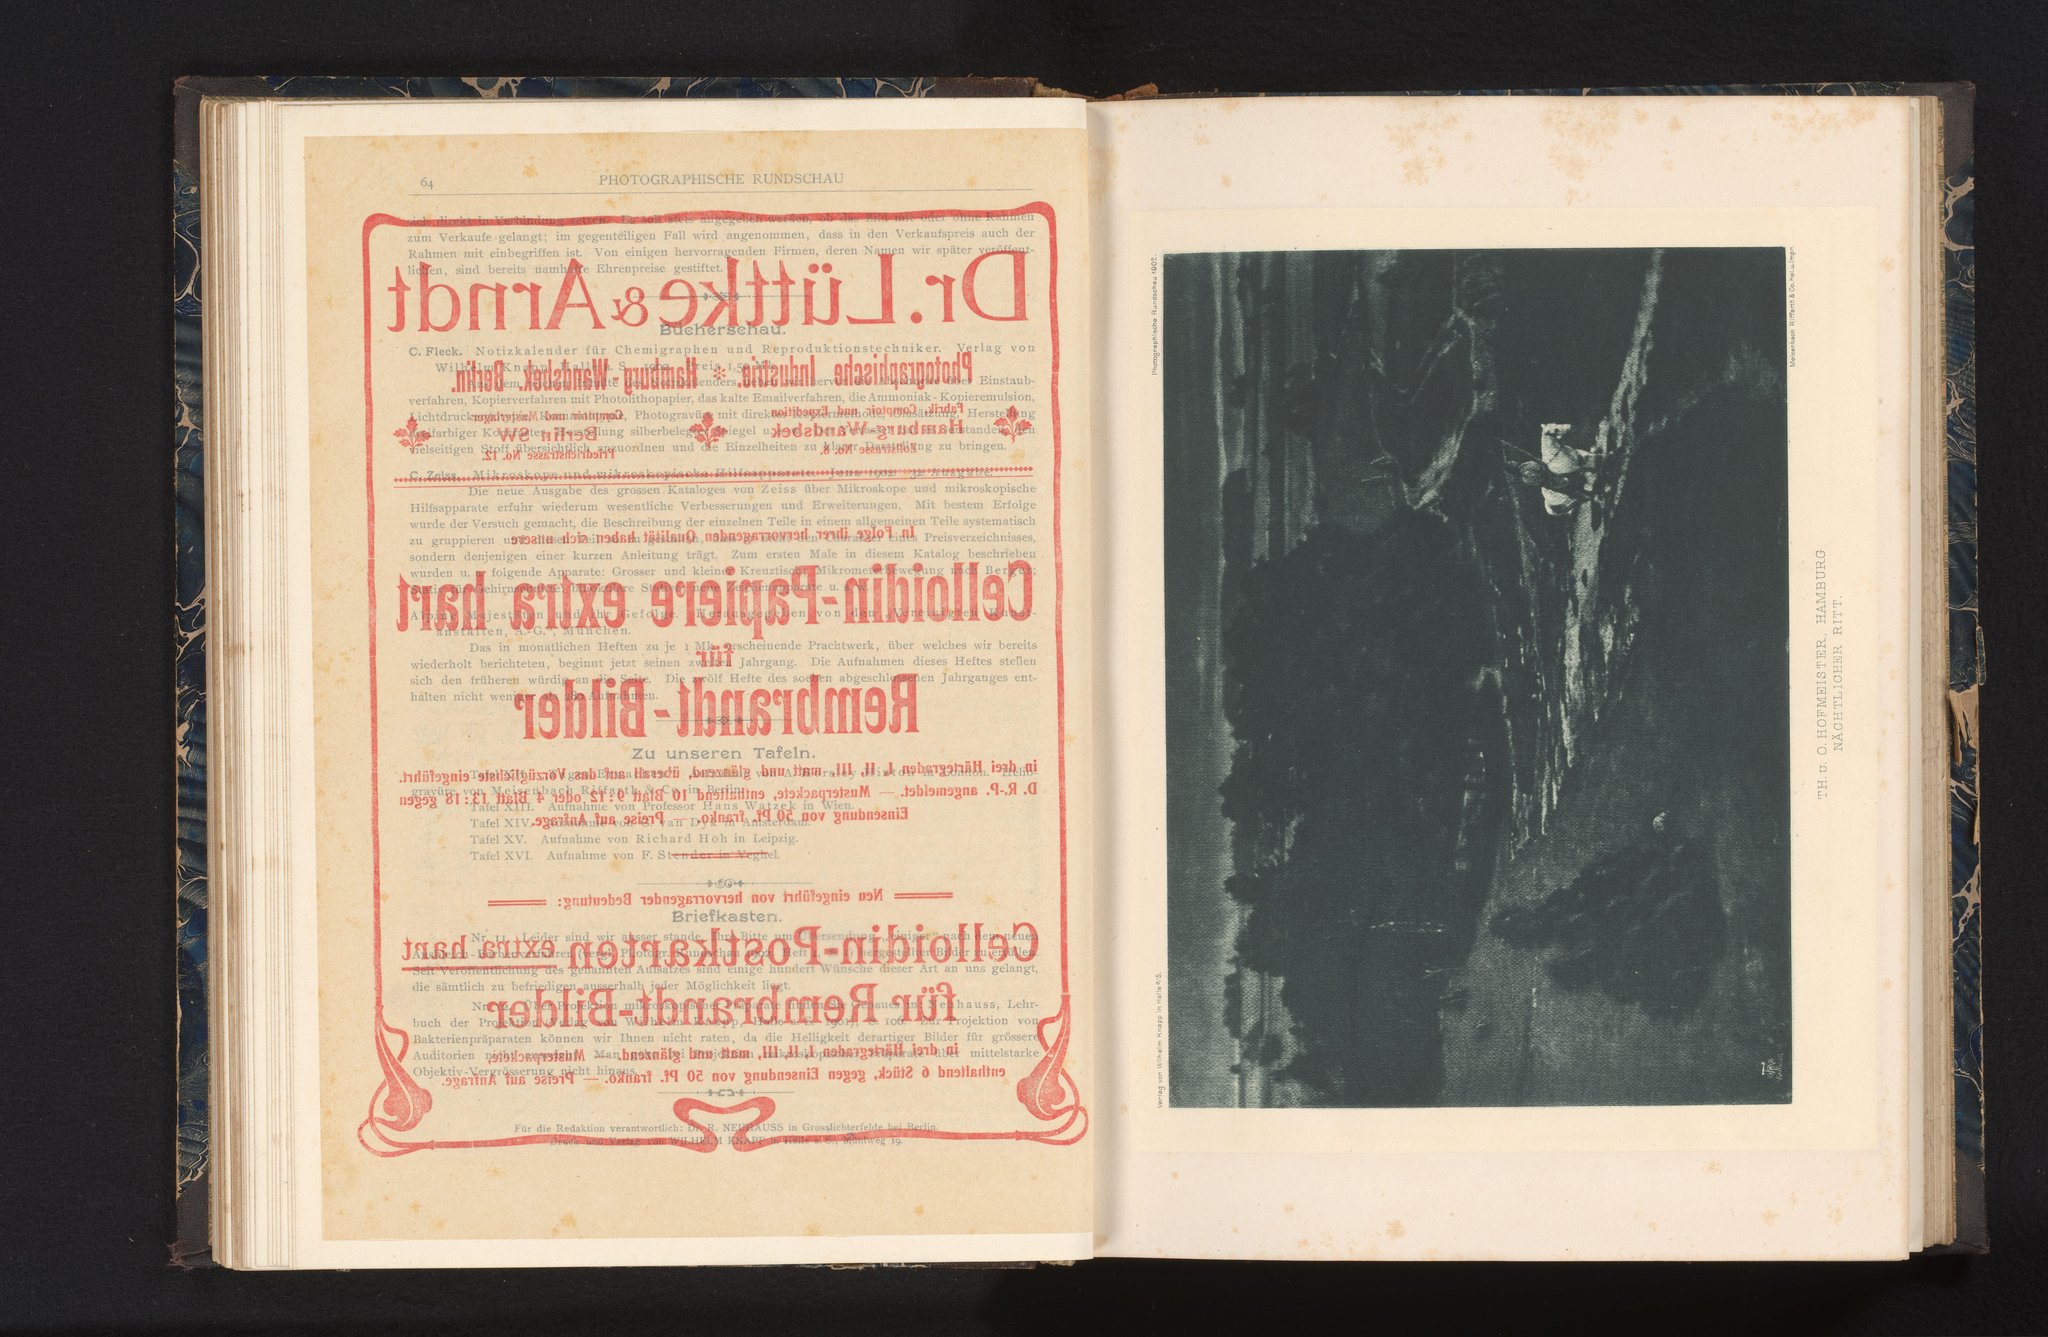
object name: page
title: Gezicht op een persoon met een paard in een landschap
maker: th. u. o. hofmeister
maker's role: fotograaf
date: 1897-1902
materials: paper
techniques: autotype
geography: berlin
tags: landscapes, horse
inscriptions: monogram: ‘[...]’